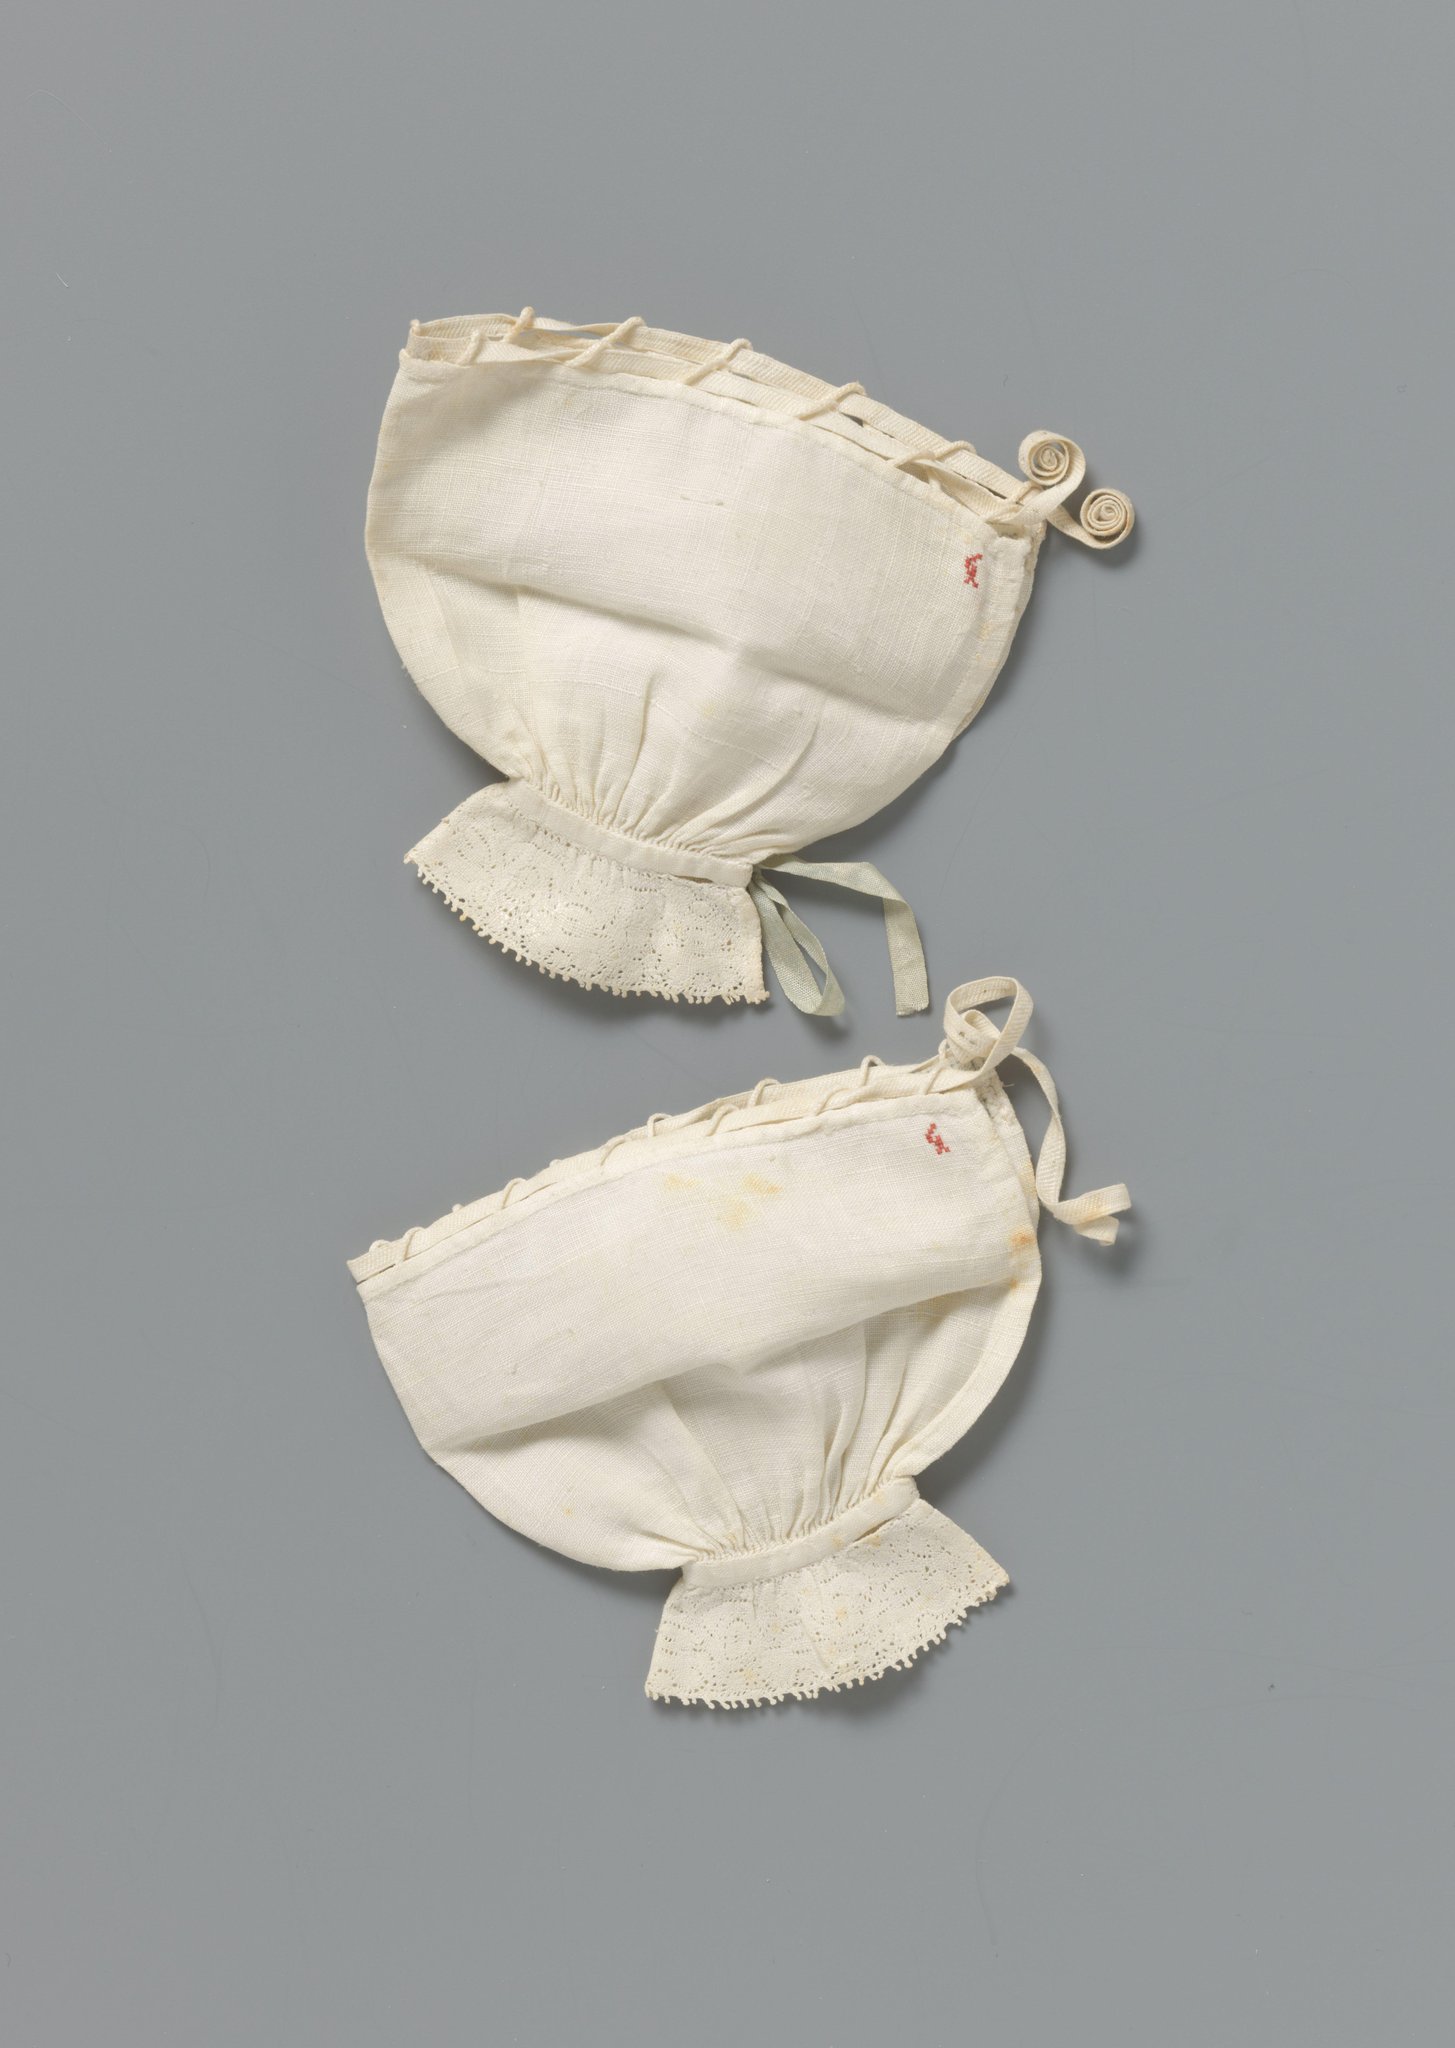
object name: miniature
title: Mouw van fijn linnen, gerimpeld tot manchet met brede strook kloskant. Knoopsgaten met lichtblauw zijden lint. Aan bovenkant strikband door schuine lussen van koord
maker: Anonymous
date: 1650-1700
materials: linen, silk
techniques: lace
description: Paar mouwen, vervaardigd van fijn linnen en gerimpeld tot een manchet, waaraan een brede strook kloskant met een dicht geweven patroon. Het kant is aan de manchet gerimpeld en laat twee knoopsgaten open, waardoorheen (bij één mouw) een lichtblauw zijden lint is gestrikt. Aan de bovenkant van de open mouwen is een koordje in schuine lussen genaaid, waardoorheen een strikbandje loopt, met strak opgerolde uiteinden. De mouwen zijn in een hoek gemerkt met het cijfer 3 of 5, in kruissteek met rood garen.